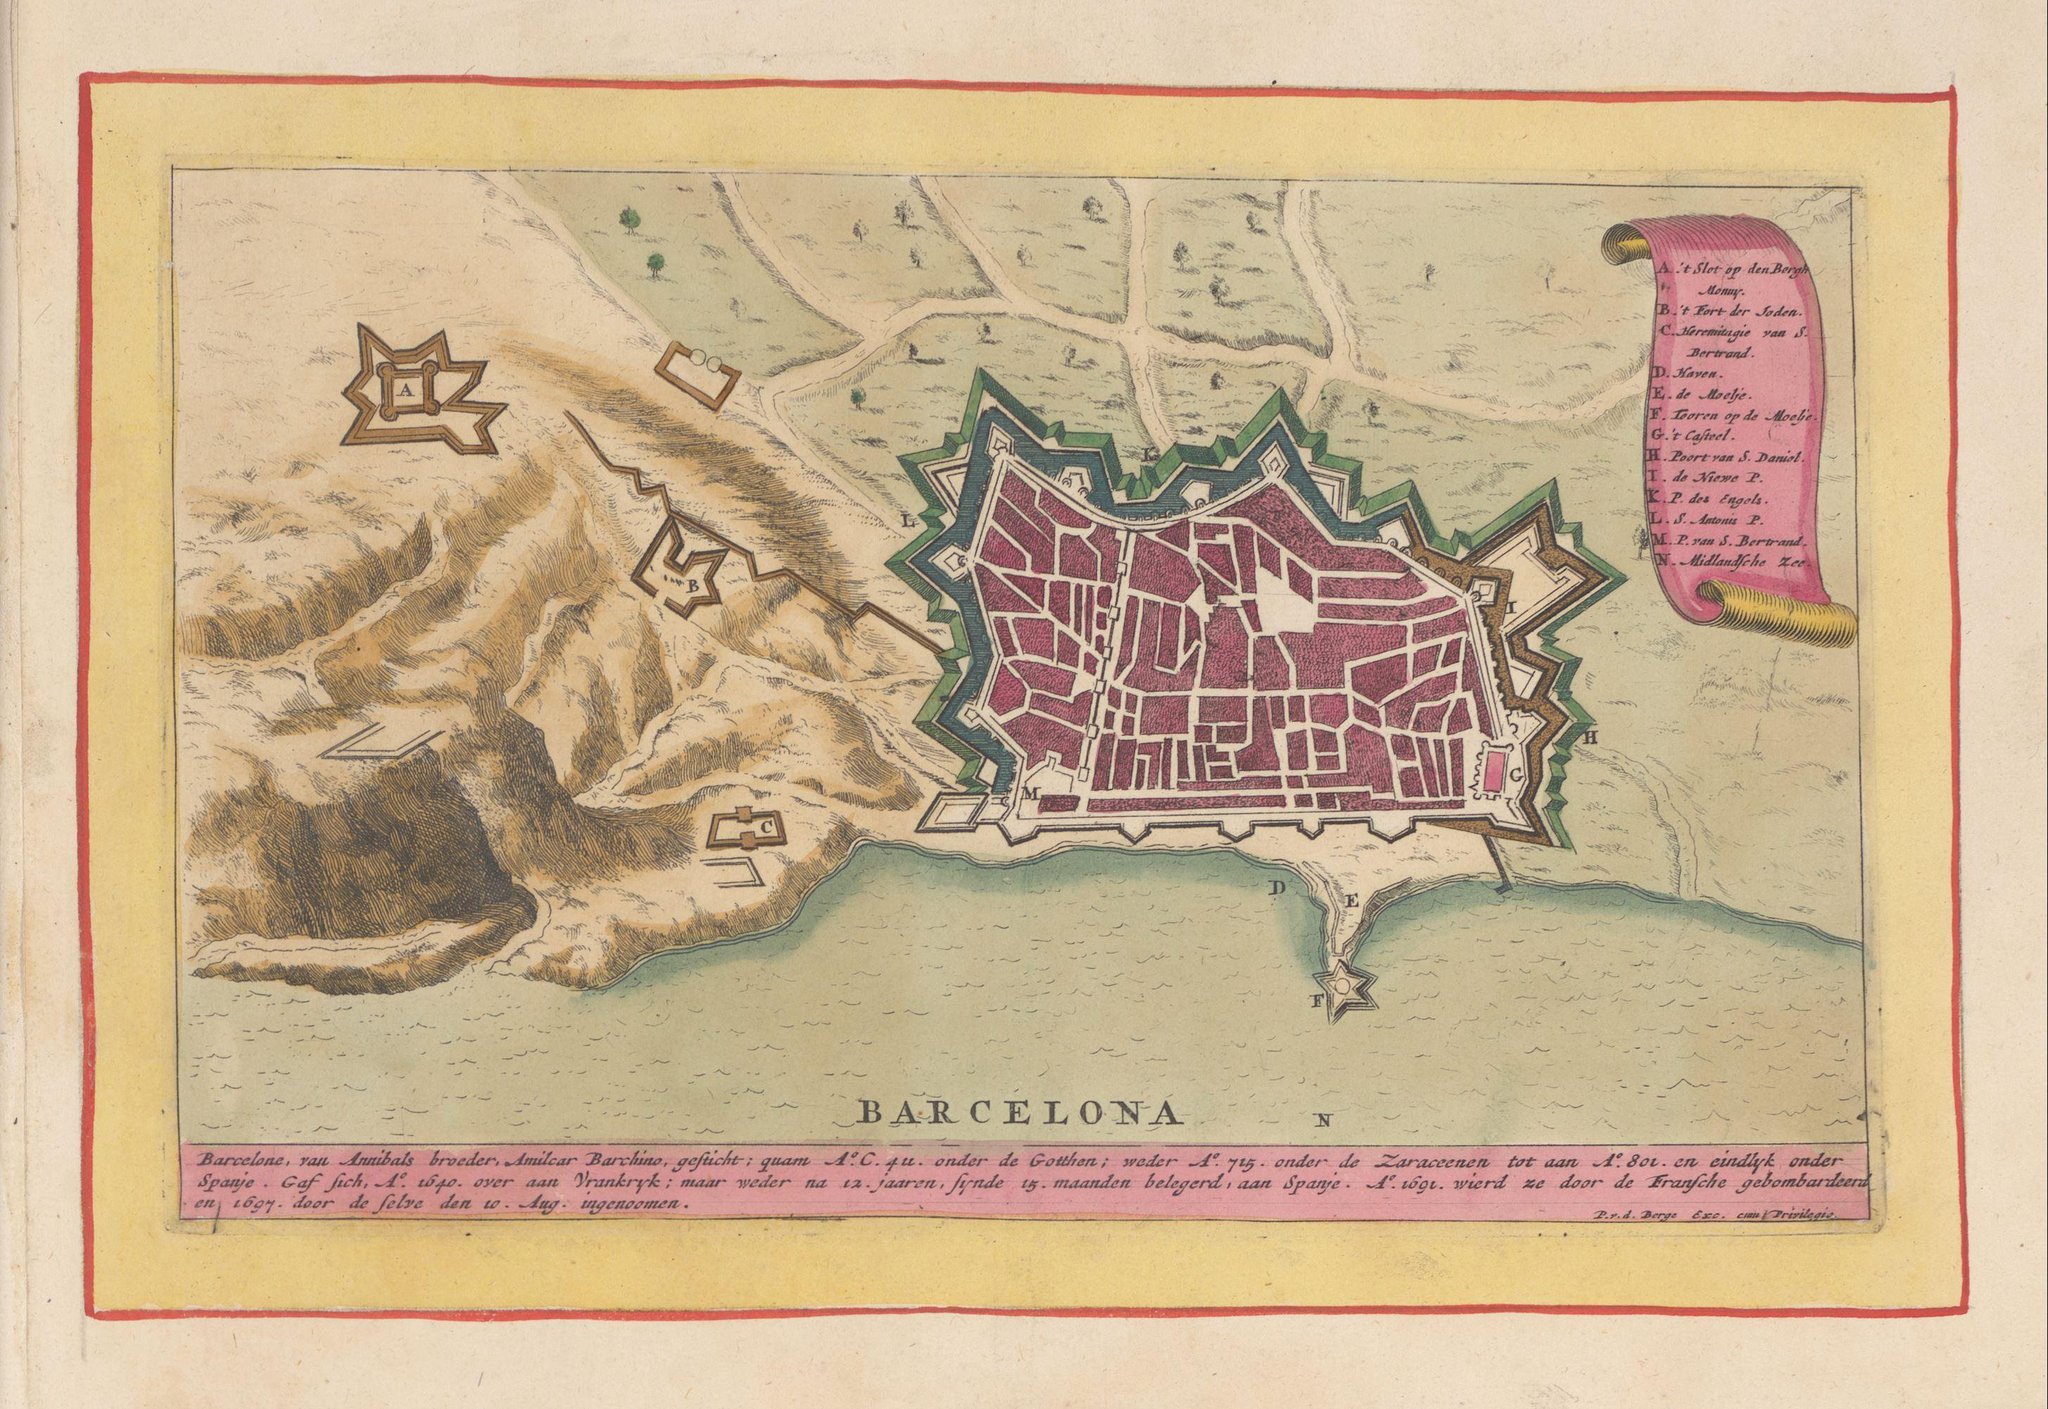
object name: map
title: Barcelona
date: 1694-1737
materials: paper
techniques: etching, hand coloring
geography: amsterdam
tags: maps of cities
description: Prent uit: Theatrum Hispaniæ, exhibens regni urbes, villas ac viridaria magis illustria. Het aanmerkelykste en voortreffelykste in Spanjen (...). Amsterdam: Pieter van den Berge, ca. 1694-1737.